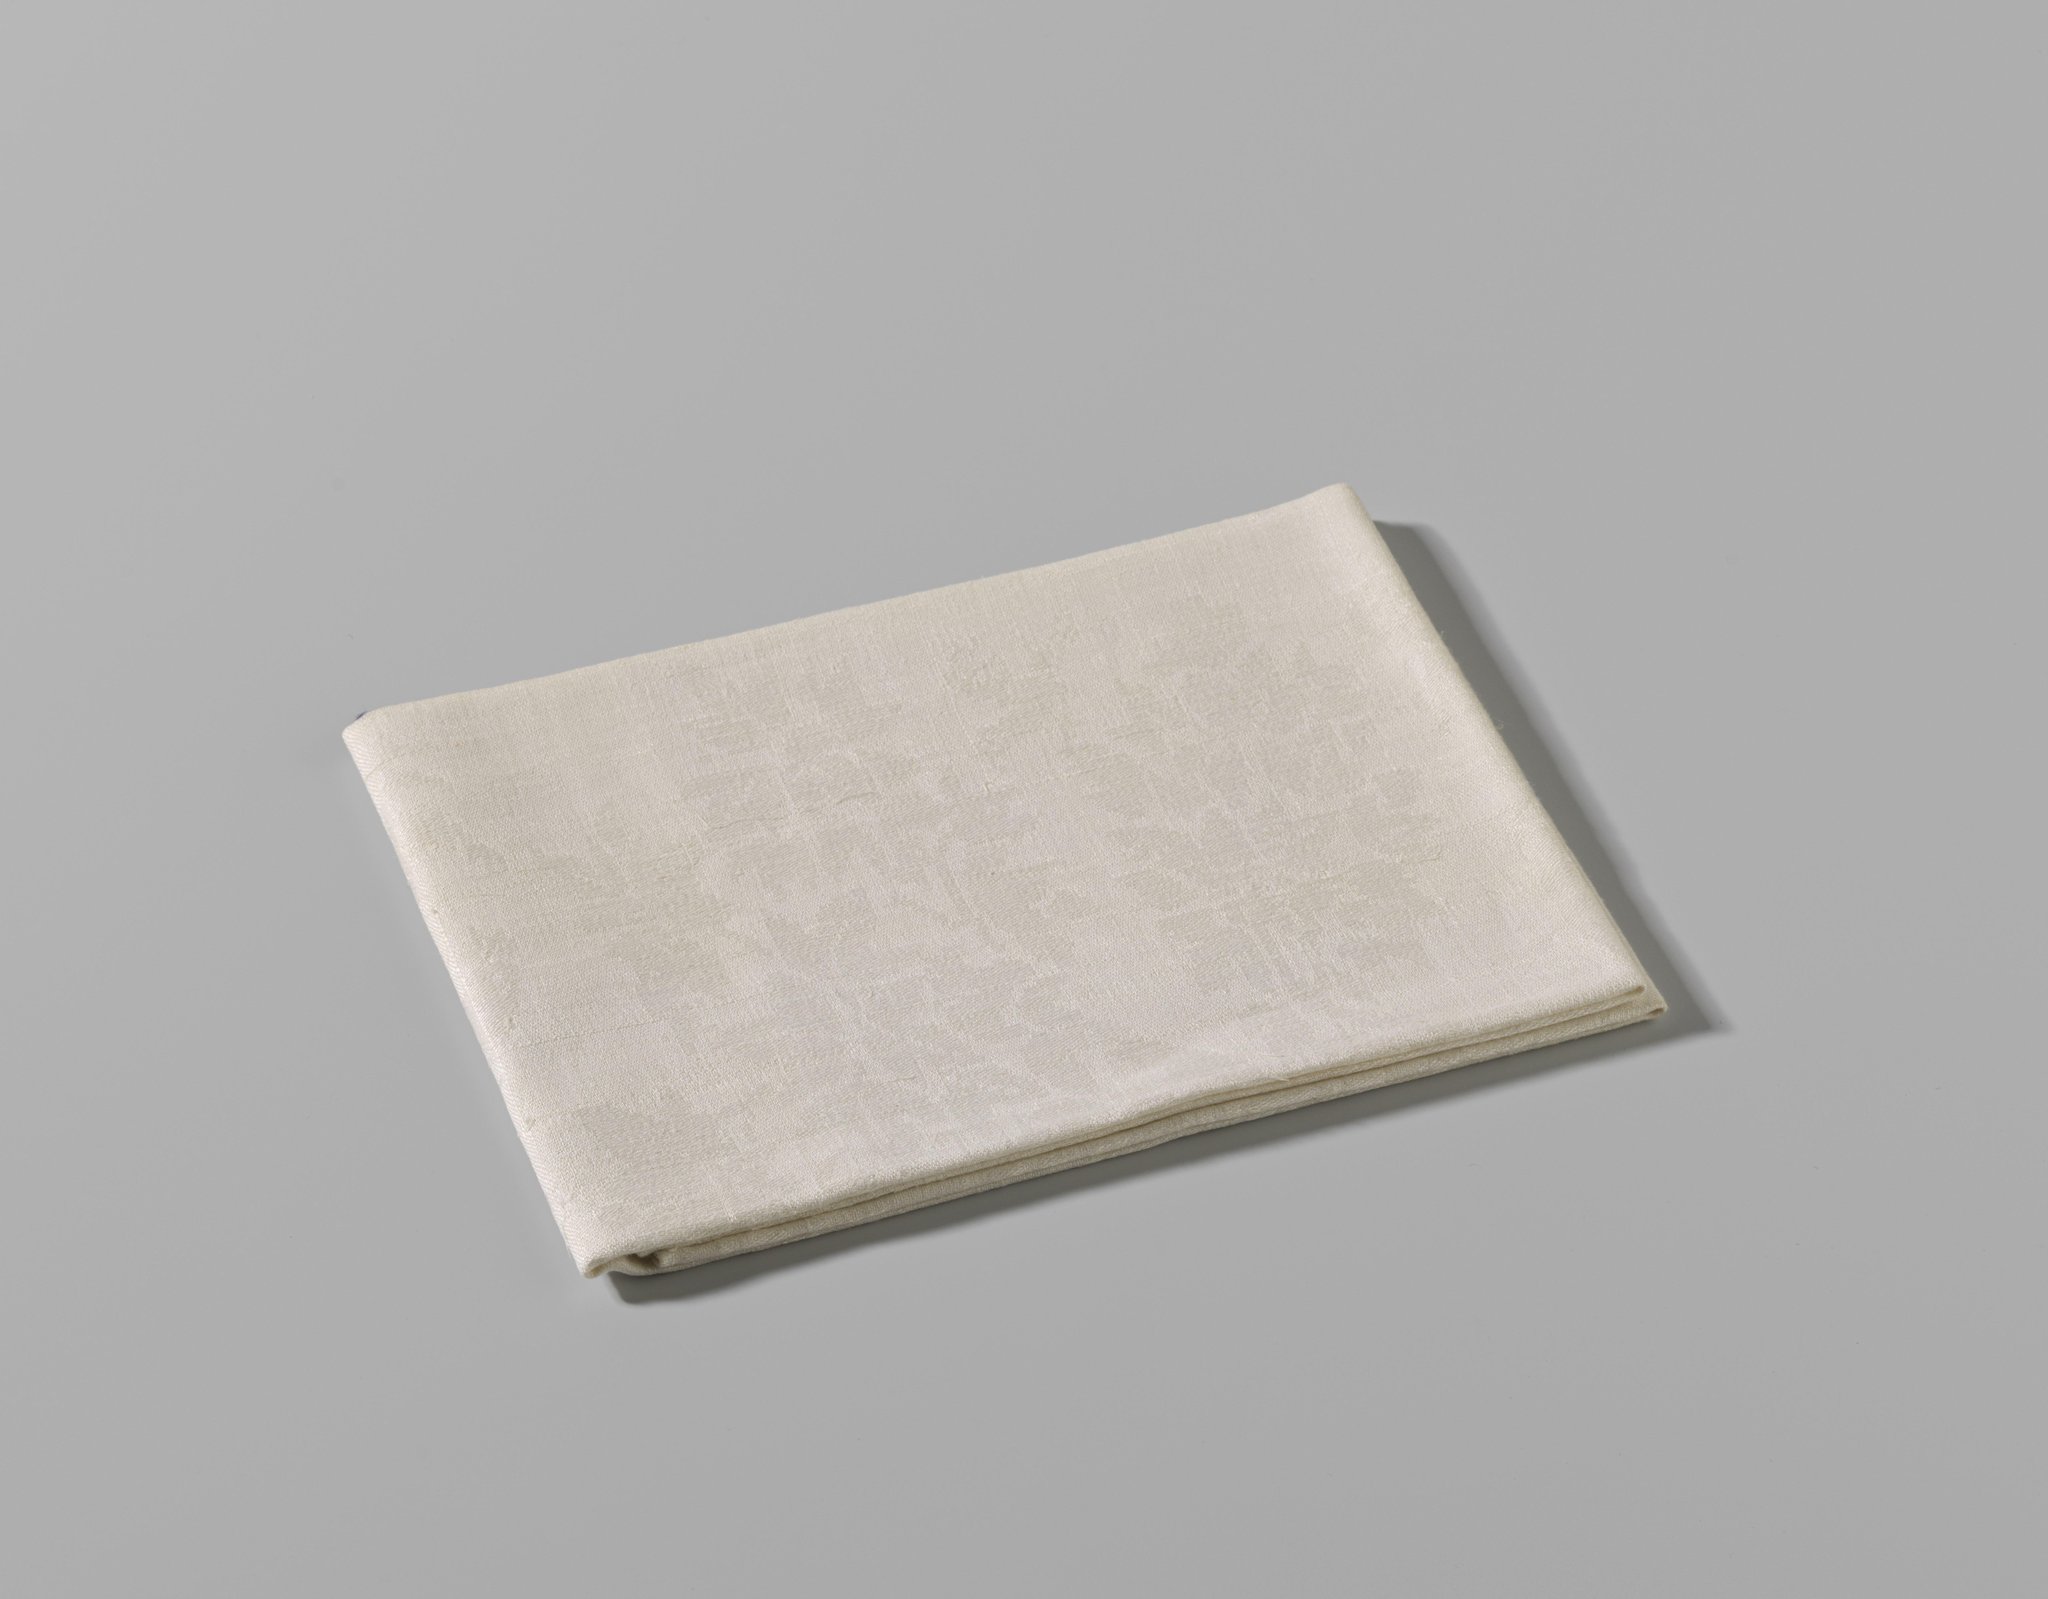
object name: napkin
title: Servet met Christus en de Samaritaanse vrouw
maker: quirijn jansz. damast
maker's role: mayor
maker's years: 1580-1638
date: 1650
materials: linen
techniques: damask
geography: haarlem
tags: christ and the woman of samaria: sitting at jacob's well he asks her for a drink from her jug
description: Servet van linnendamast met Christus en de Samaritaanse vrouw bij de put. Middenveld: het symmetrische patroon vertoont van onder naar boven twee taferelen: 1 Christus en de Samaritaanse vrouw bij de put, waarboven een katrol. Een vogeltje boven het hoofd van de vrouw. 2 Twee discipelen komen met een mand met brood uit een stad, waarvan de poort geopend is. Onder deze voorstelling de tekst IOAN IIII. Staande randen: een enkele slingerrand waartussen vogels en bloemen. Het servet heeft geen liggende randen.